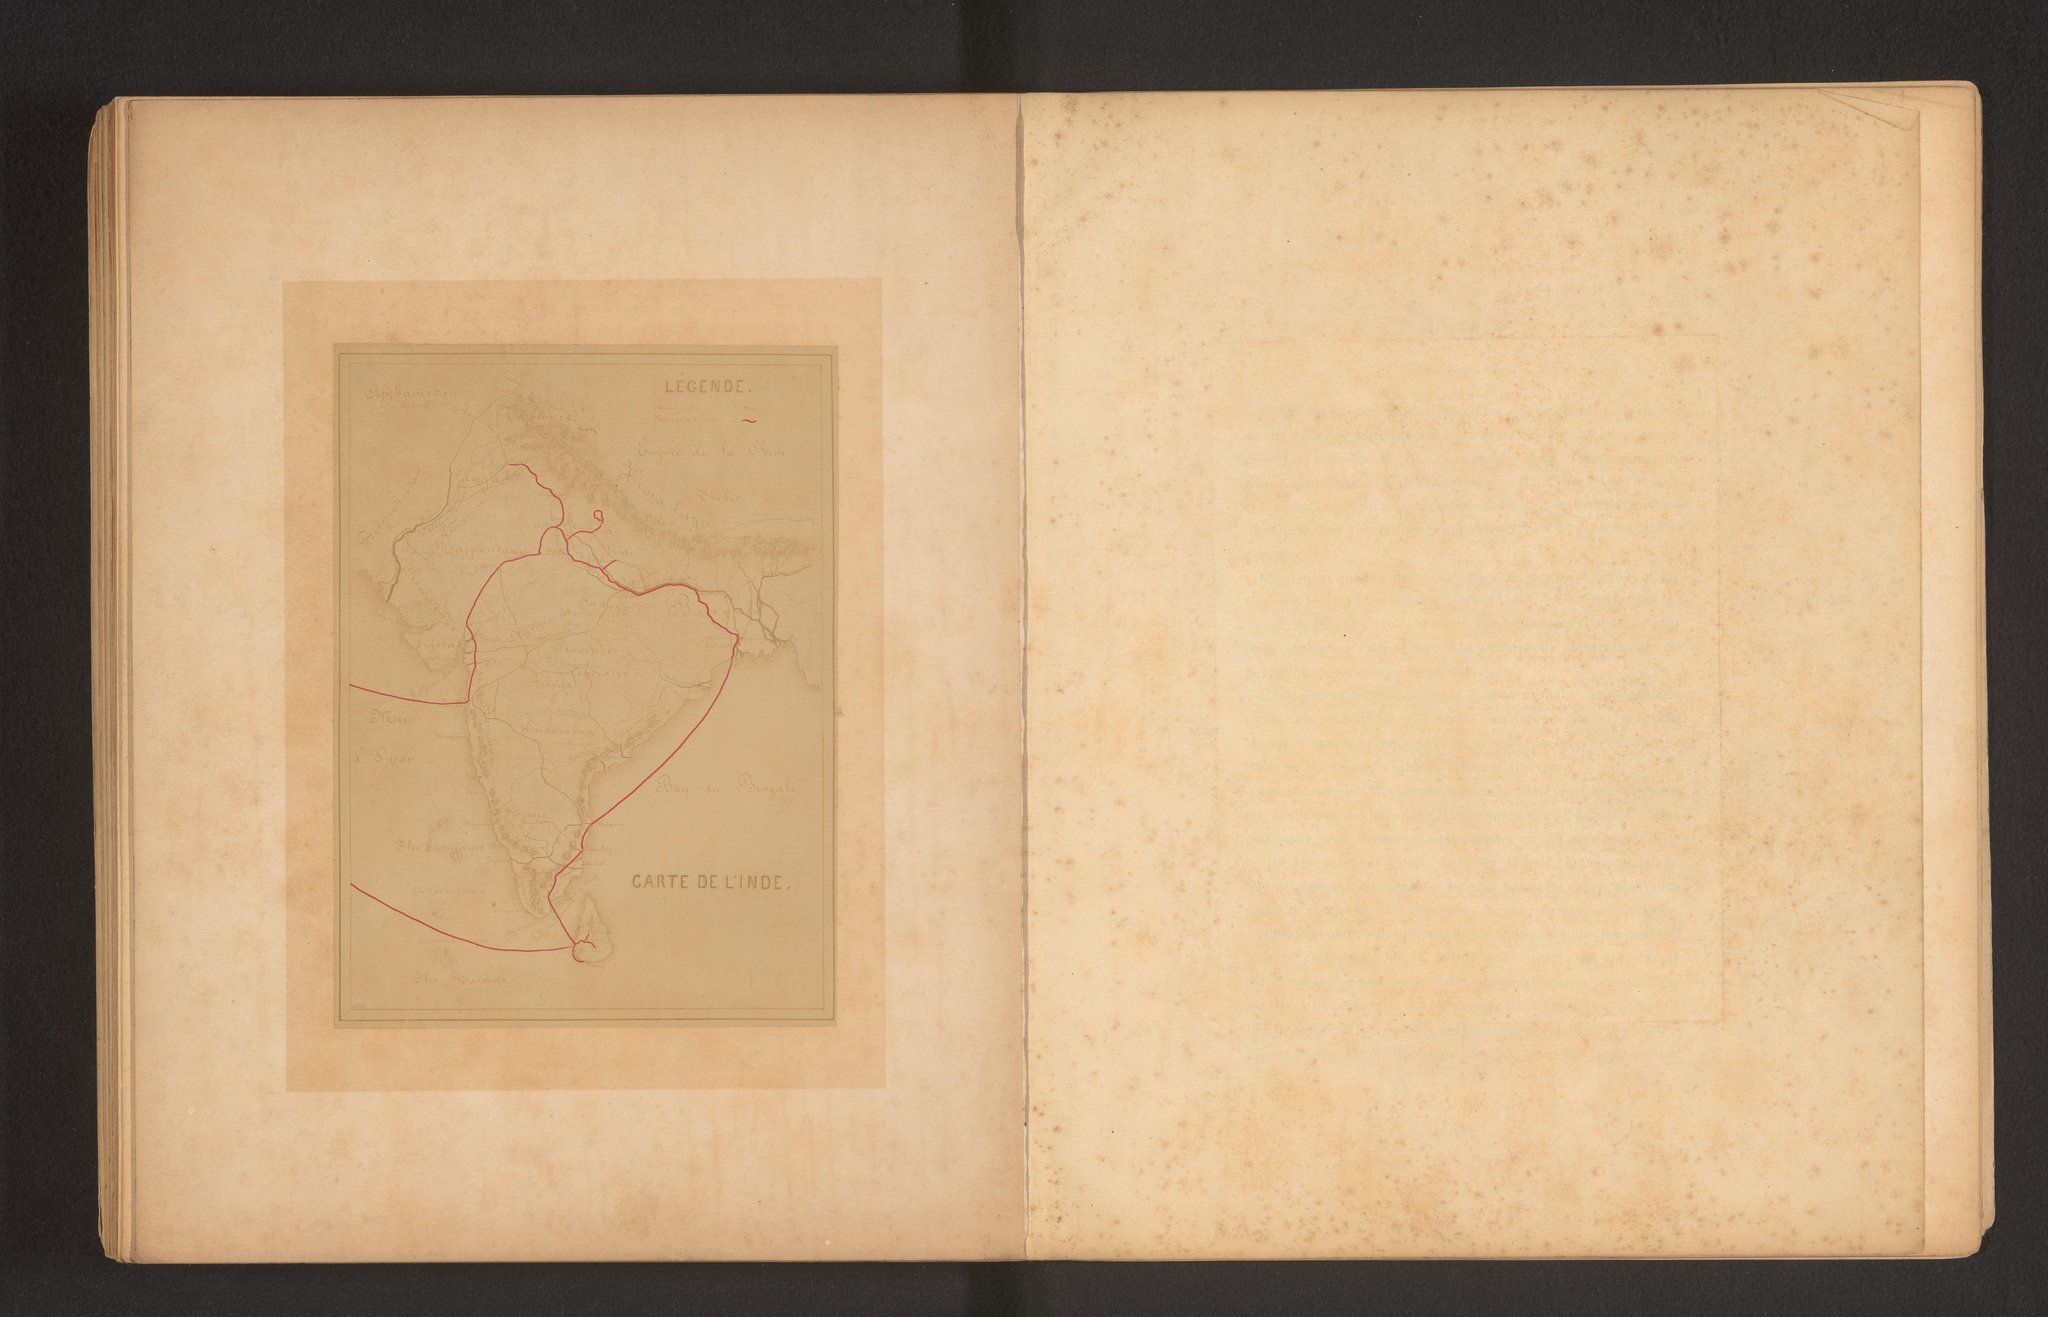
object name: photograph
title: Carte de l'Inde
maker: alexandre (fotograaf)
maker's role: fotograaf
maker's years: 1855-1925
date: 1880-1885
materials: photographic support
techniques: albumen print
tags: maps of separate countries or regions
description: Foto tegenover pagina 131, achter omslag.